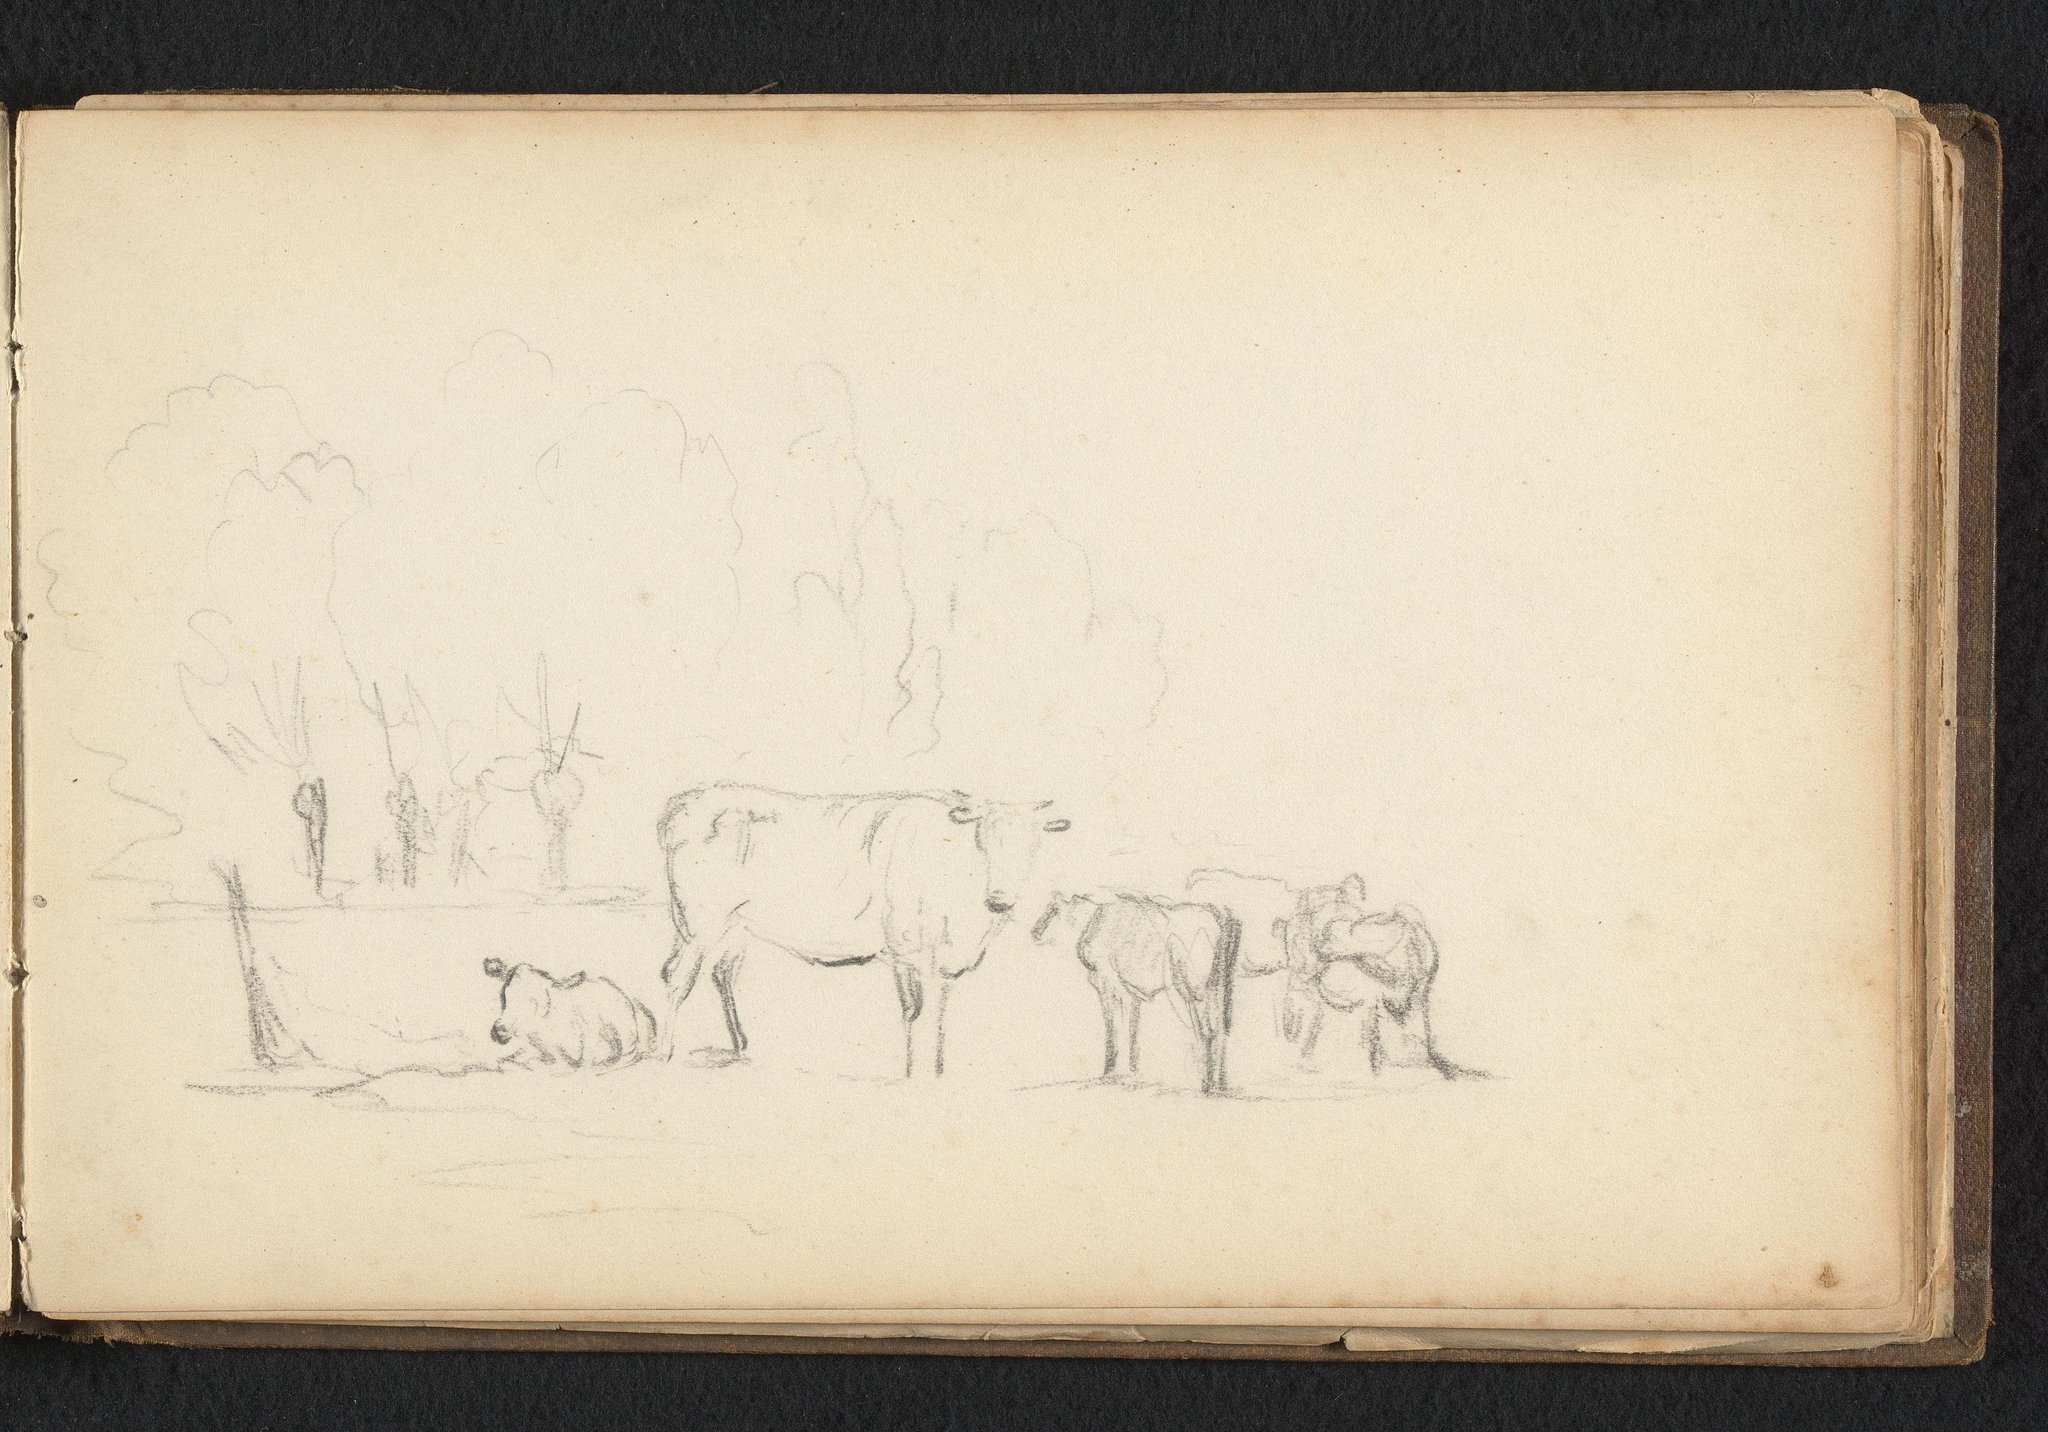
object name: sketchbook leaf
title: Vijf koeien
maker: jan bedijs tom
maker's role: draughtsman, painter, print maker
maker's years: 1813-1894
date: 1823-1894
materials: paper, pencil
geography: the hague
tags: cow, meadow, pasture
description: Pagina 23 verso uit een schetsboek met 37 bladen.